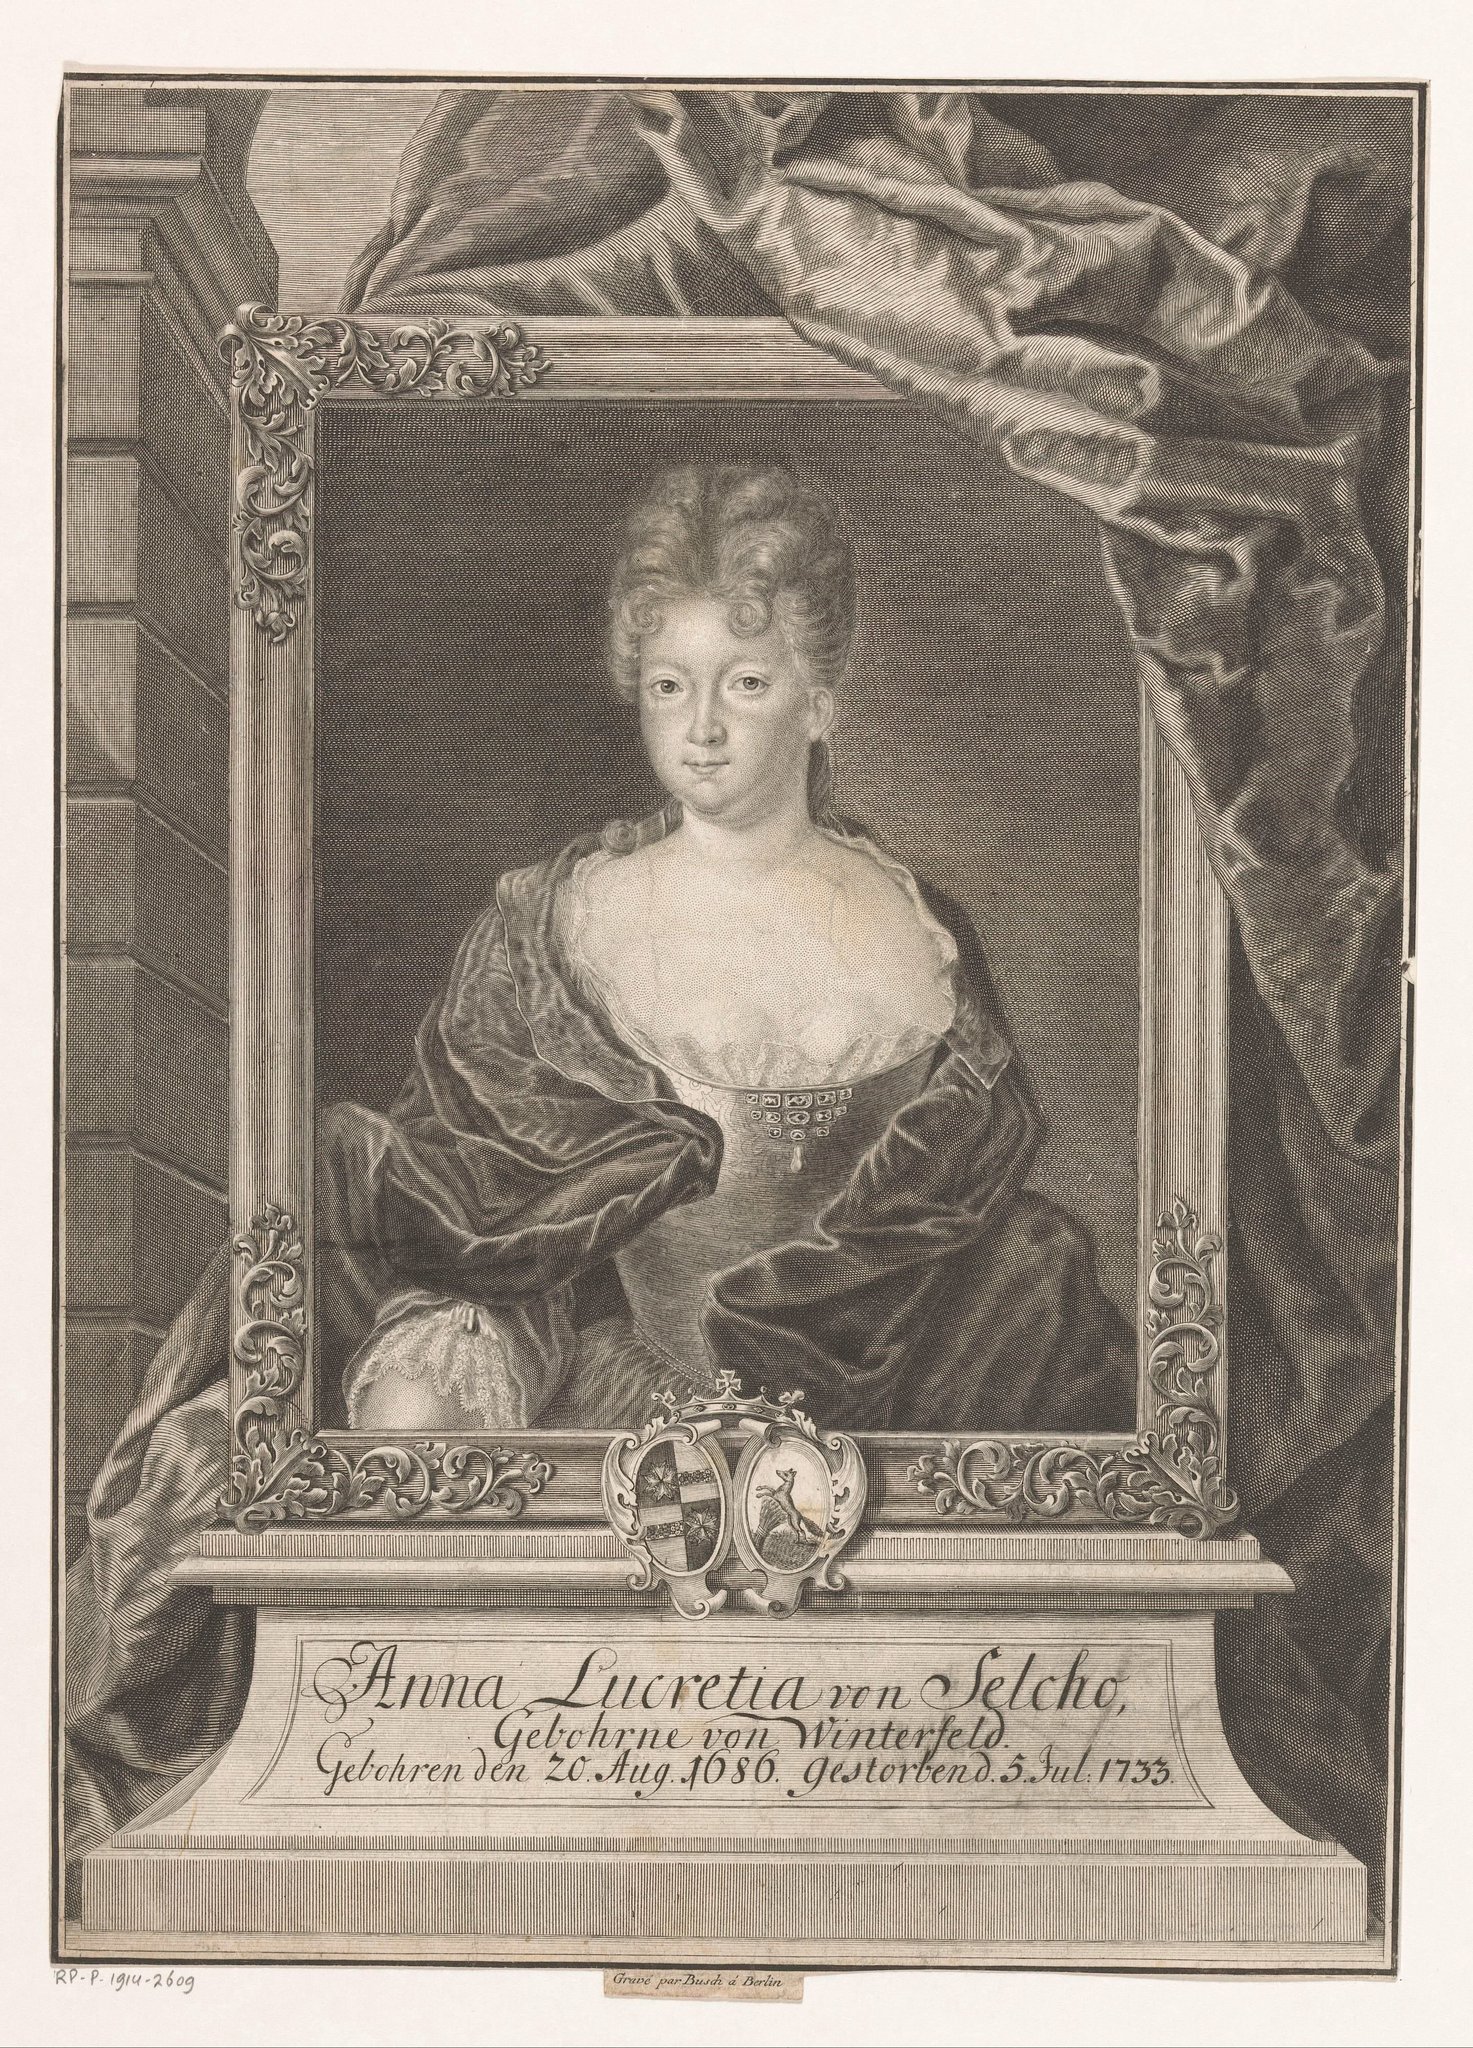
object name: print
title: Portret van Anna Lucretia von Selcho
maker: georg paul busch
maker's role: print maker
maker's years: -1756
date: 1733-1756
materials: paper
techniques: engraving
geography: berlin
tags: historical persons - bb - woman, armorial bearing, heraldry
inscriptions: collector's mark: Lugt 2228